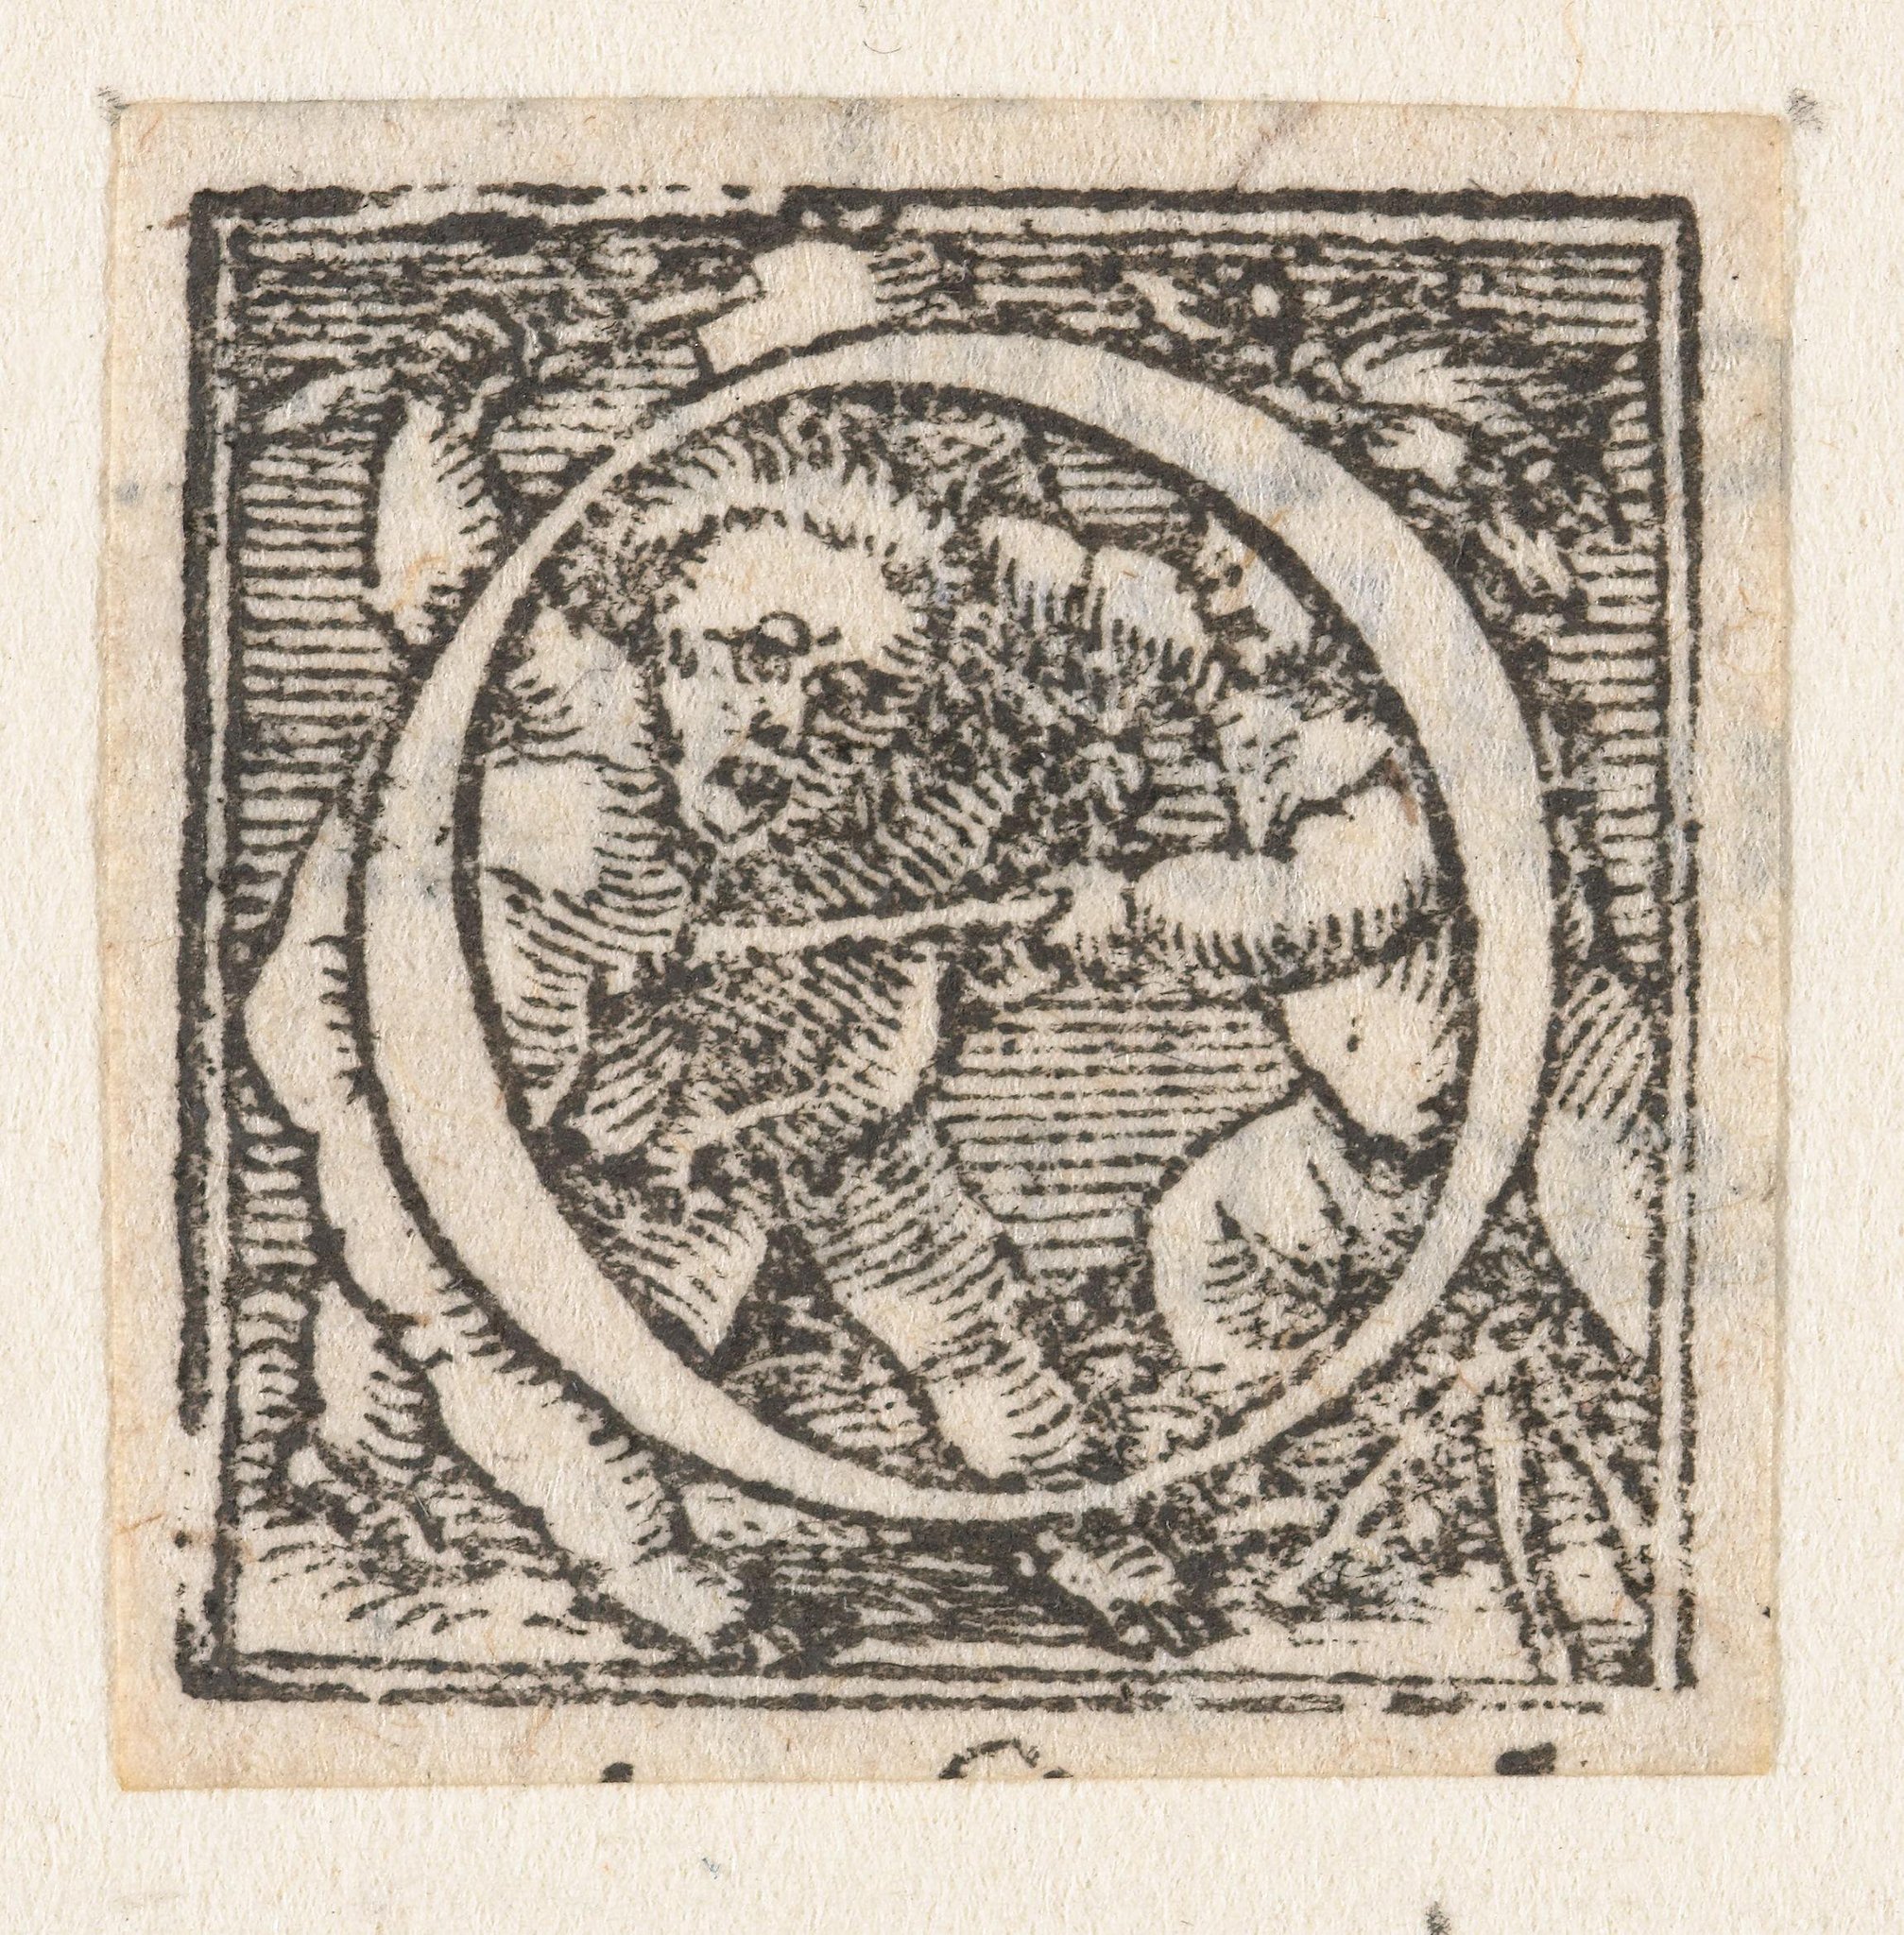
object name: print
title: Alfabet met kinderen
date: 1522-1526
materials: paper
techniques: woodcut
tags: letters, alphabet, script, child